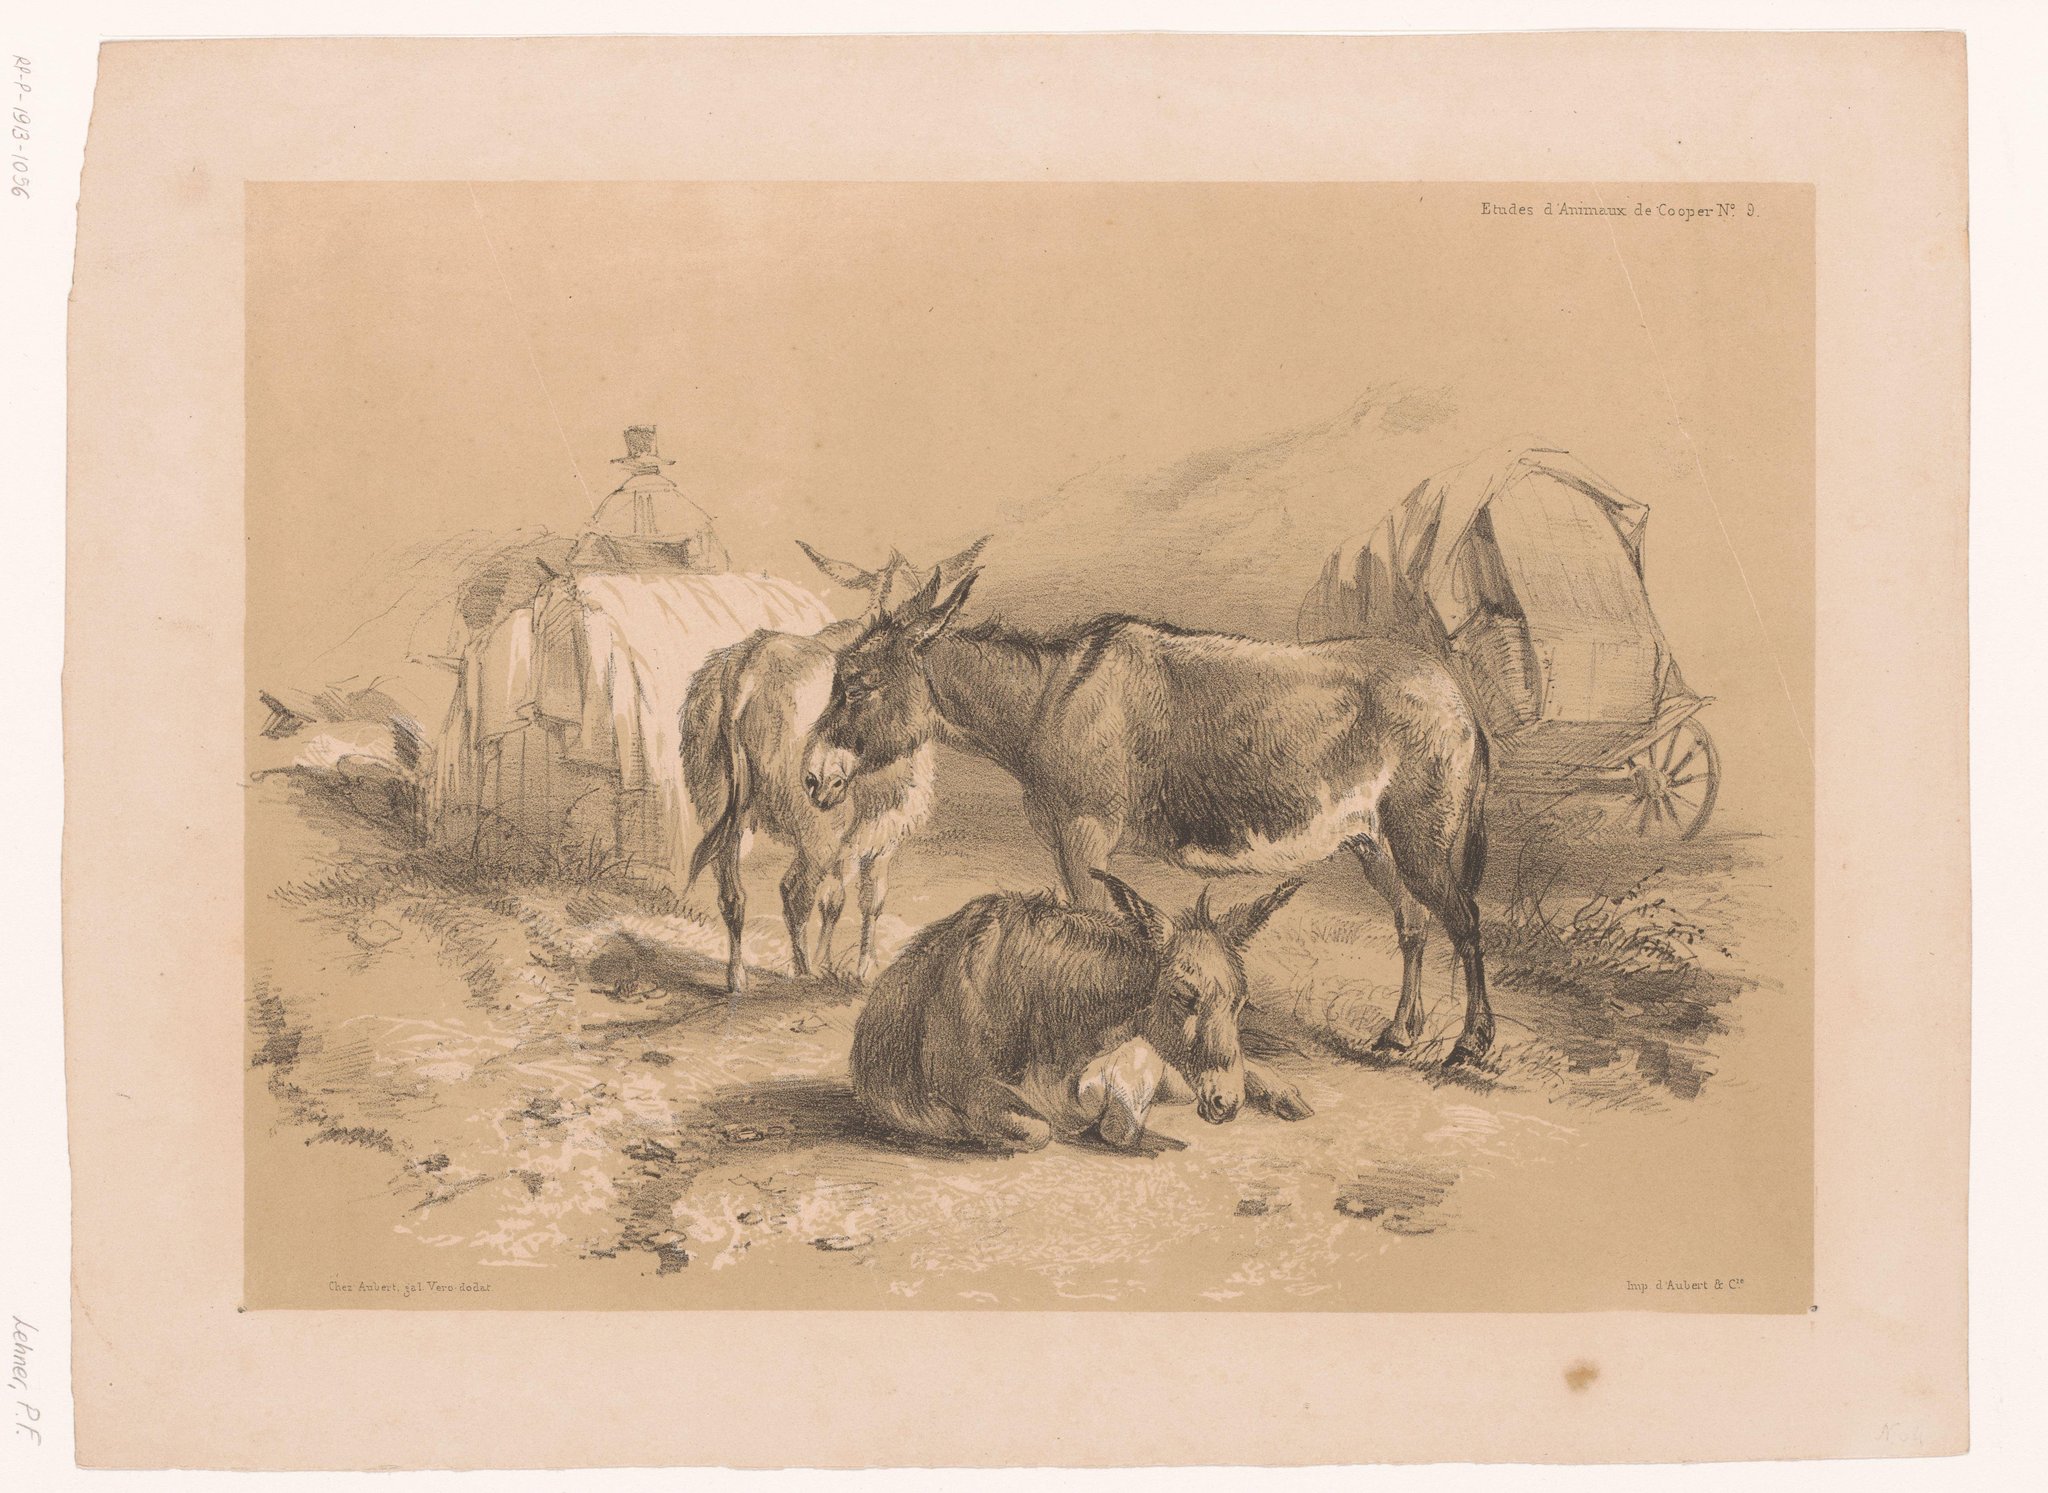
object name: print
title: Studie van drie ezels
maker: pierre frédéric lehnert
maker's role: print maker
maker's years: 1811-1880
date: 1838-1840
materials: paper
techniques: tone lithography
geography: paris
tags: ass, donkey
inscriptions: collector's mark: Lugt 2228a